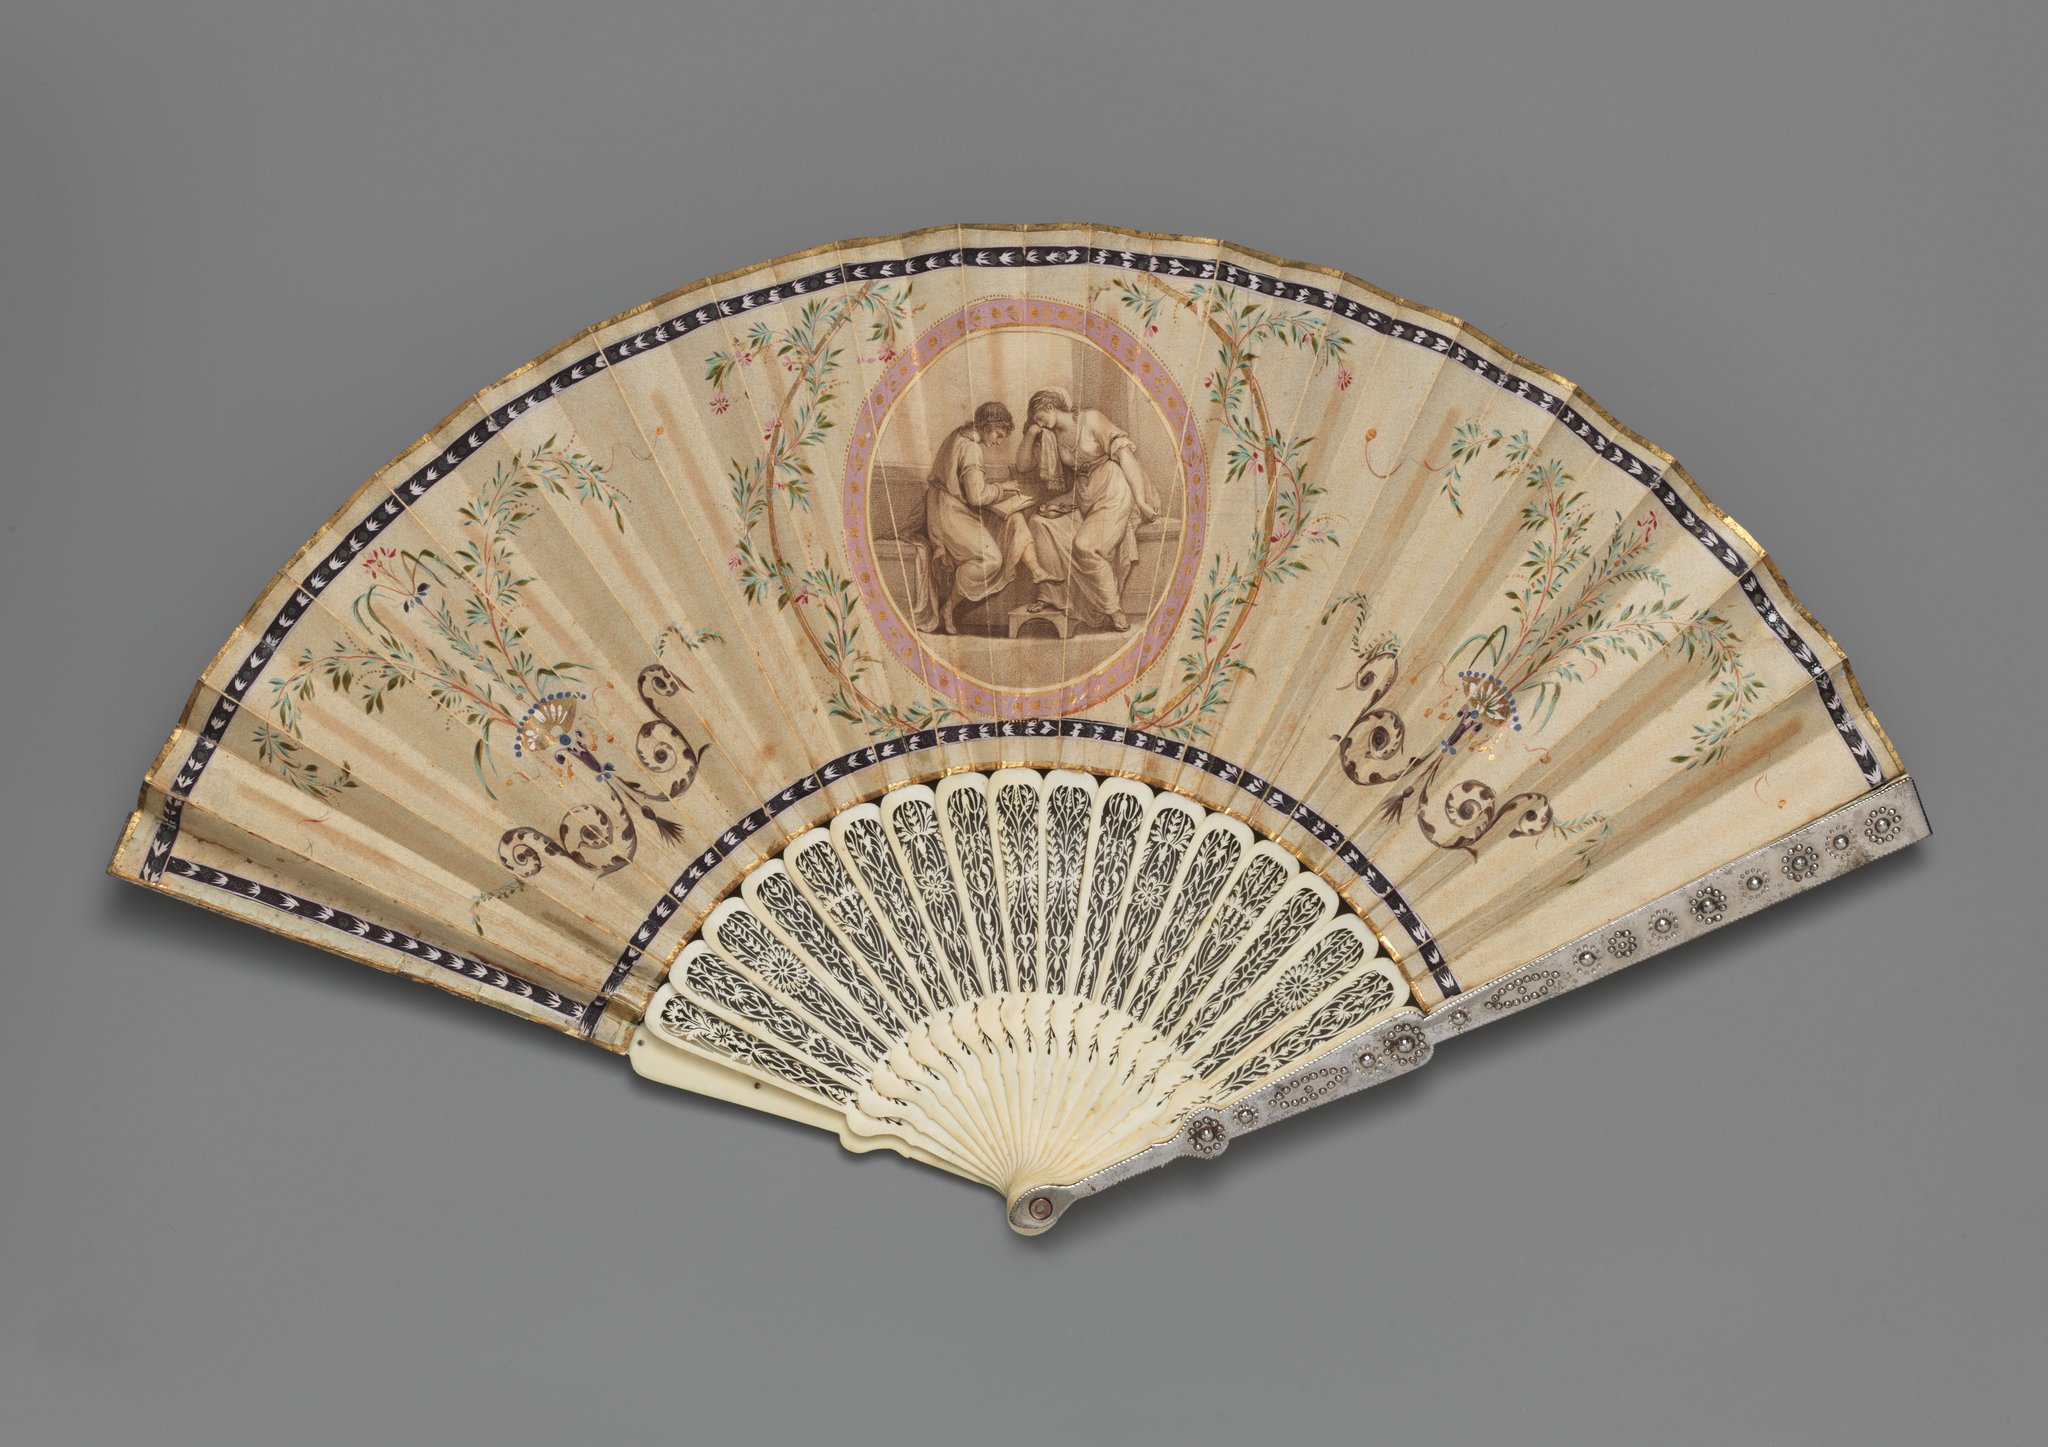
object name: fan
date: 1767-1800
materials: ivory, paper, steel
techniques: cutting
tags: men,women